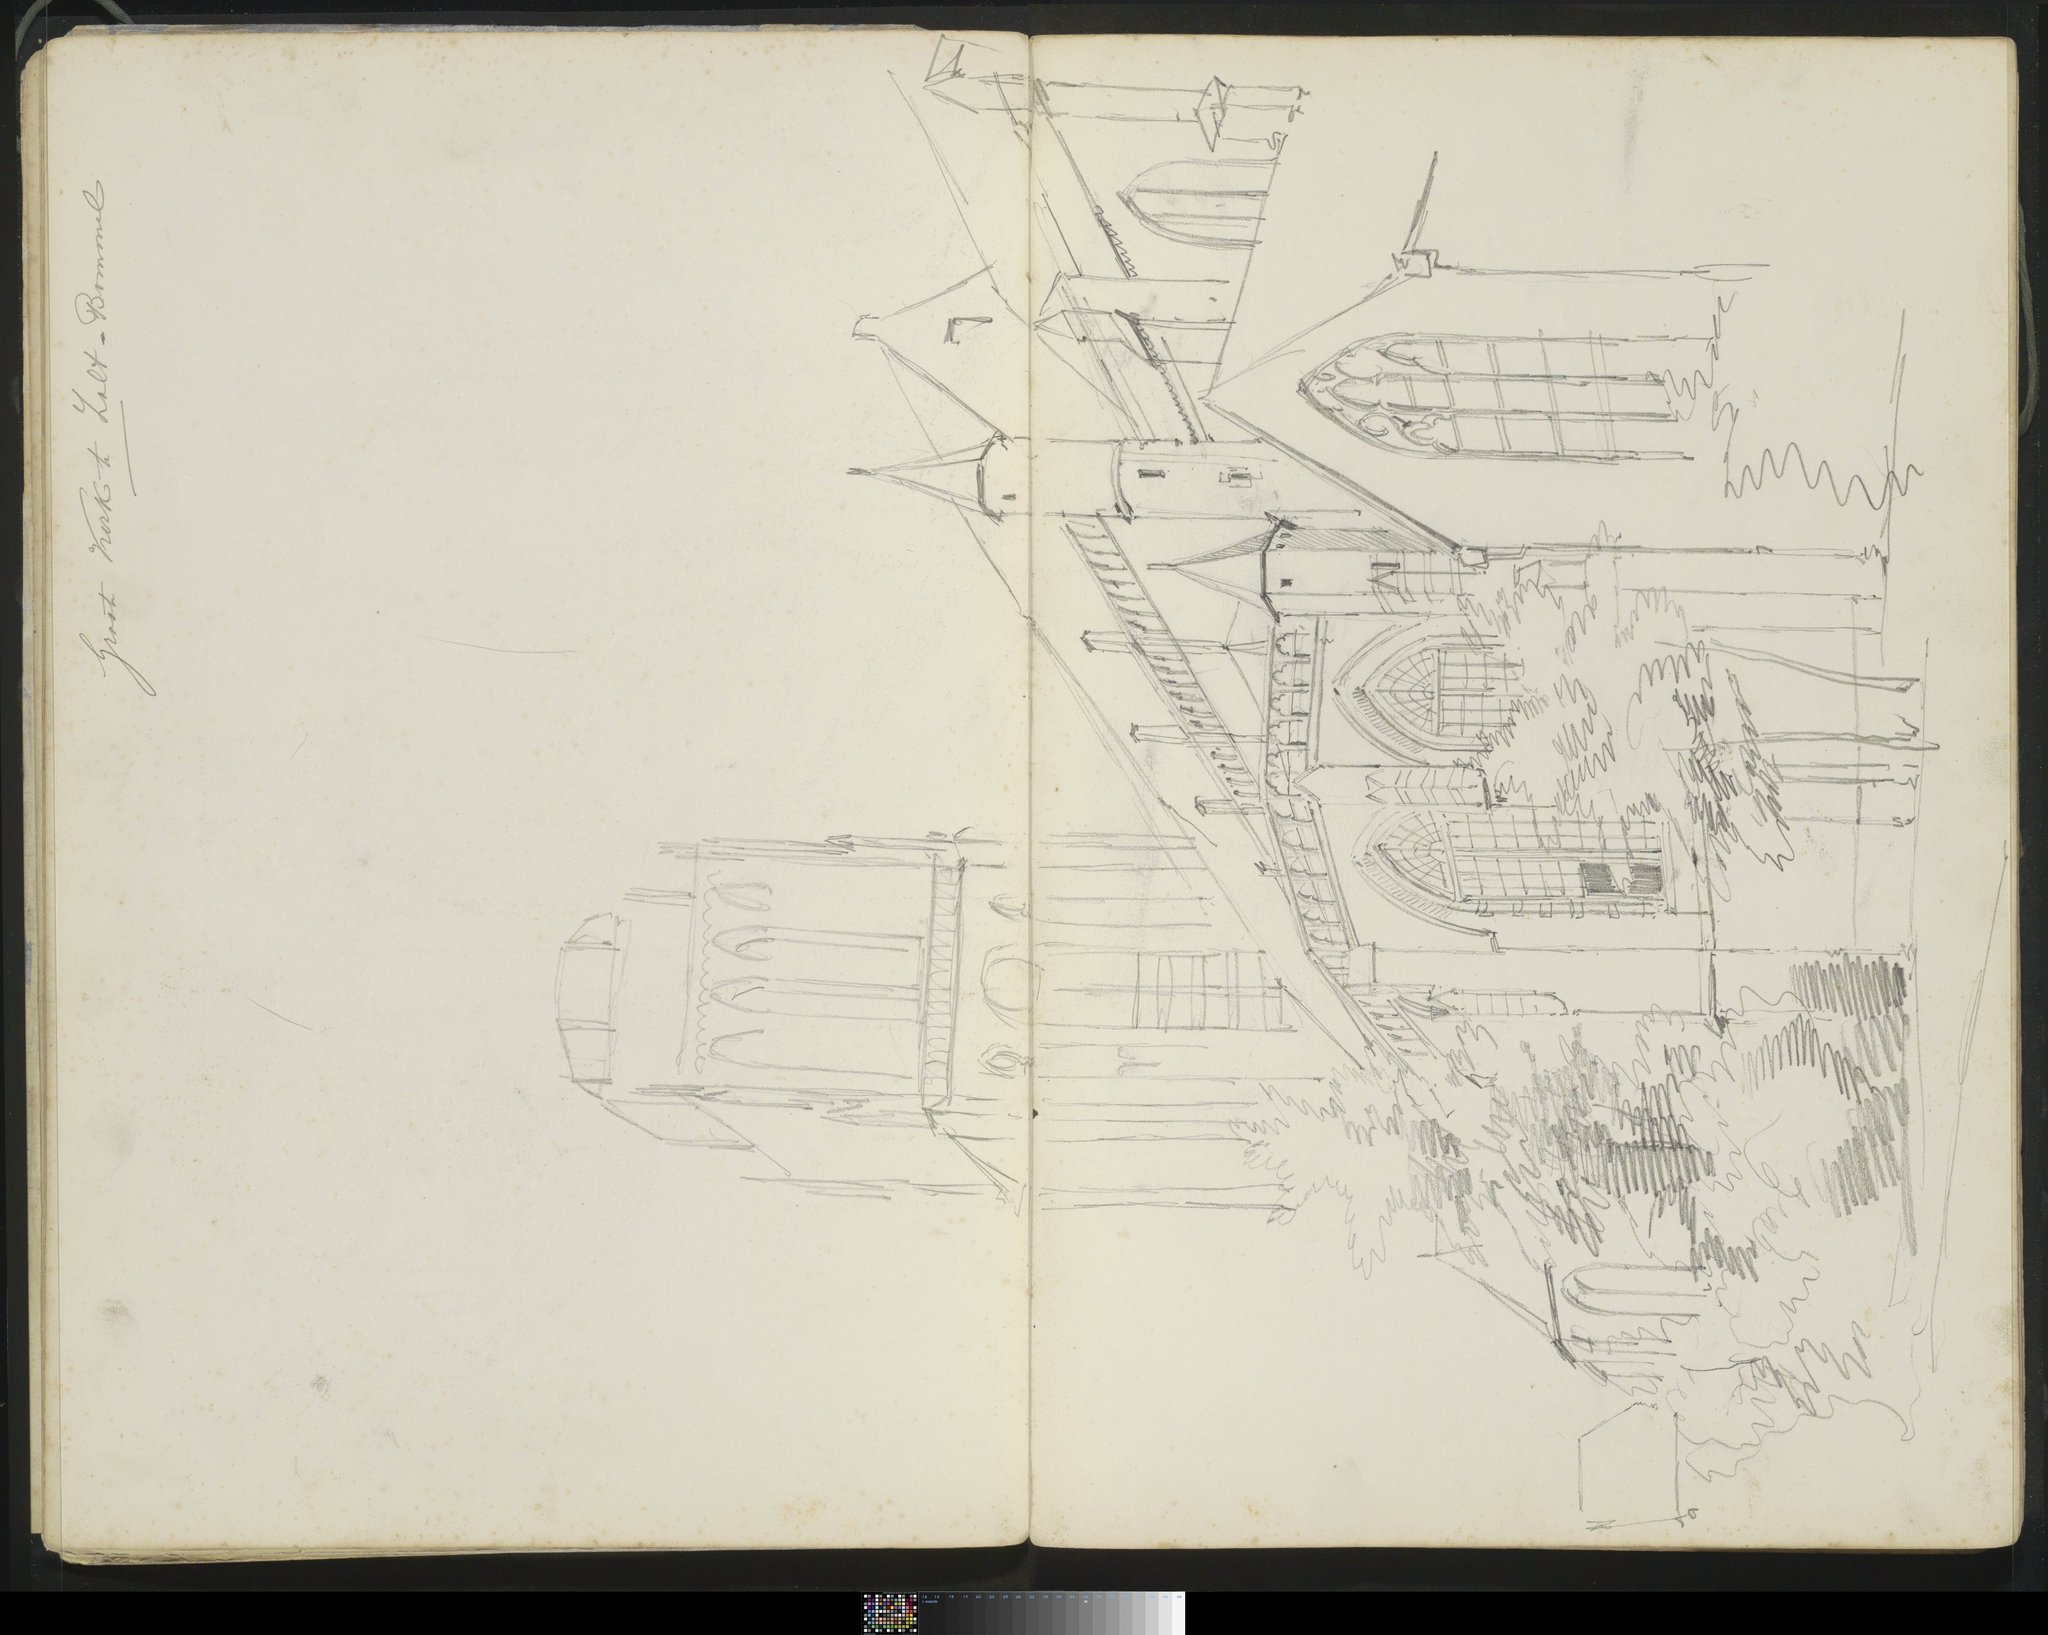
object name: sketchbook leaf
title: Grote Kerk te Zaltbommel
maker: willem koekkoek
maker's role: draughtsman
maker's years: 1839-1895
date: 1849-1895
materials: paper, pencil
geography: zaltbommel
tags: church (exterior)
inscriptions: annotation: ‘Groote Kerk te Zalt-Bommel’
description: Blad 9 verso en 10 recto uit een schetsboek met 35 bladen.